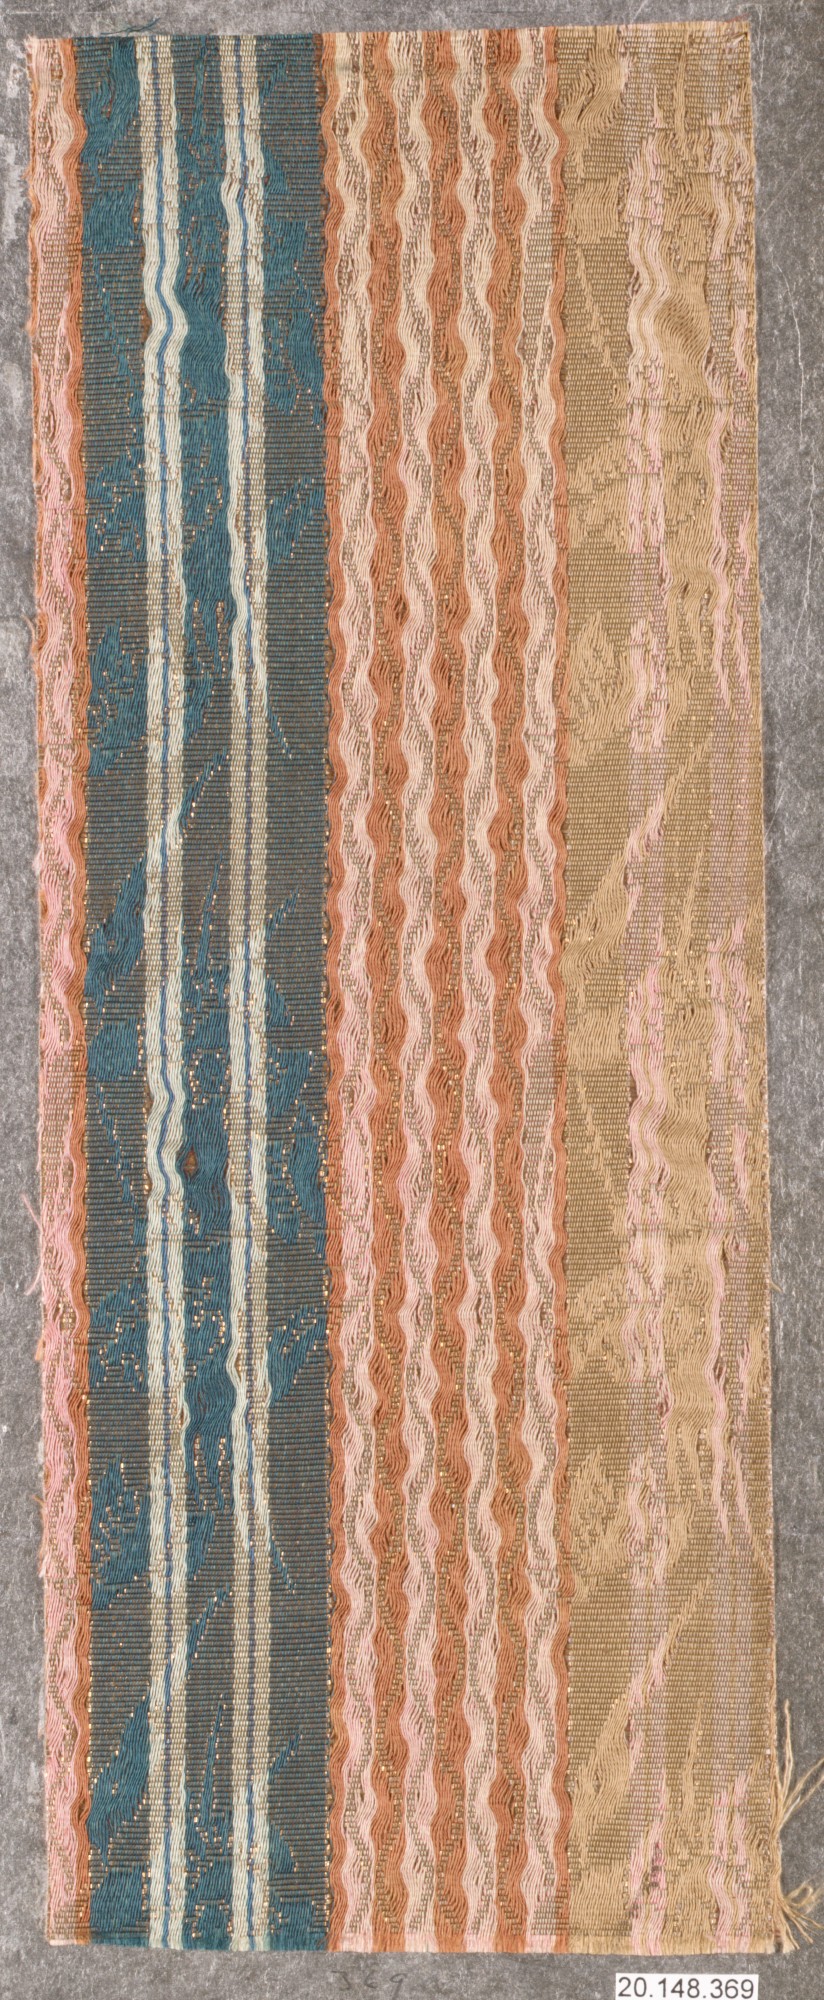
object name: piece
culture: japanese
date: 1701-1800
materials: silk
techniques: compound weave